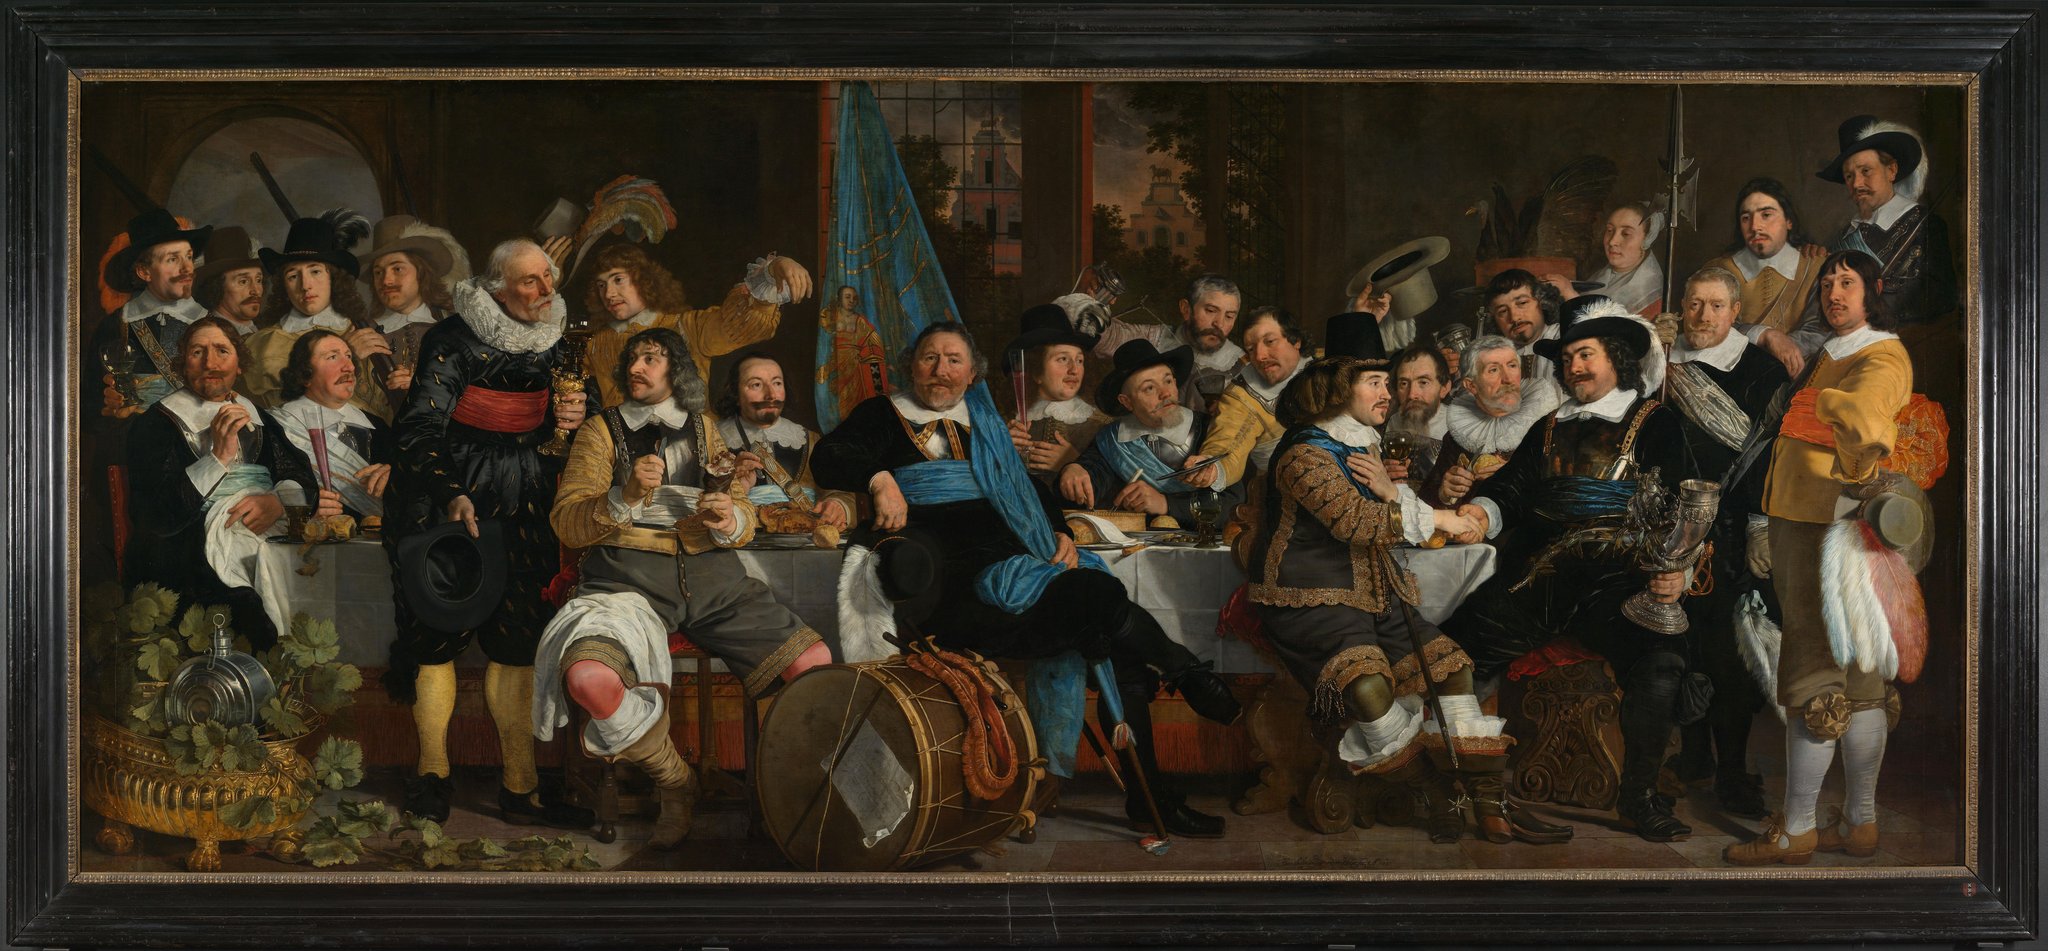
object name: painting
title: The Celebration of the Peace of Münster, 18 June 1648, in the Headquarters of the Crossbowmen's Civic Guard (St George Guard), Amsterdam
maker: bartholomeus van der helst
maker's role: draughtsman, painter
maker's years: 1613-1670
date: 1648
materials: canvas, oil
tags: mayor, cornelis witsen, warfare; military affairs (+ citizen soldiery, civil guard, citizen militia), glass, rummer, celebration meal, feast, banquet, (military) flags and standards, private festivities, merry company, amsterdam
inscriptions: inscription: ‘Belloone walgt van Bloedt / ja Mars vervloeckt het daveren / Van't zwangere metaal, / en 't zwaardt bemint de schee: / Dies biedt de dapp're Wits / aan d'eedele van Waveren / Op 't eeuwige verbondt, / den hooren van de Vree.’, signature and date: ‘Bartholomeus Vander Helst, fecit Aº 1648.’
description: 18 June 1648: a banquet is taking place at the Amsterdam crossbowmen’s guild. The occasion was the signing of the Treaty of Münster, which marked an end to the war with Spain. The captains of the civic guard company shake hands as a sign of peace, and the drinking horn is passed around. The poem on the drum proclaims the joy of Amsterdam’s armed militia that their weapons can henceforth be laid to rest.